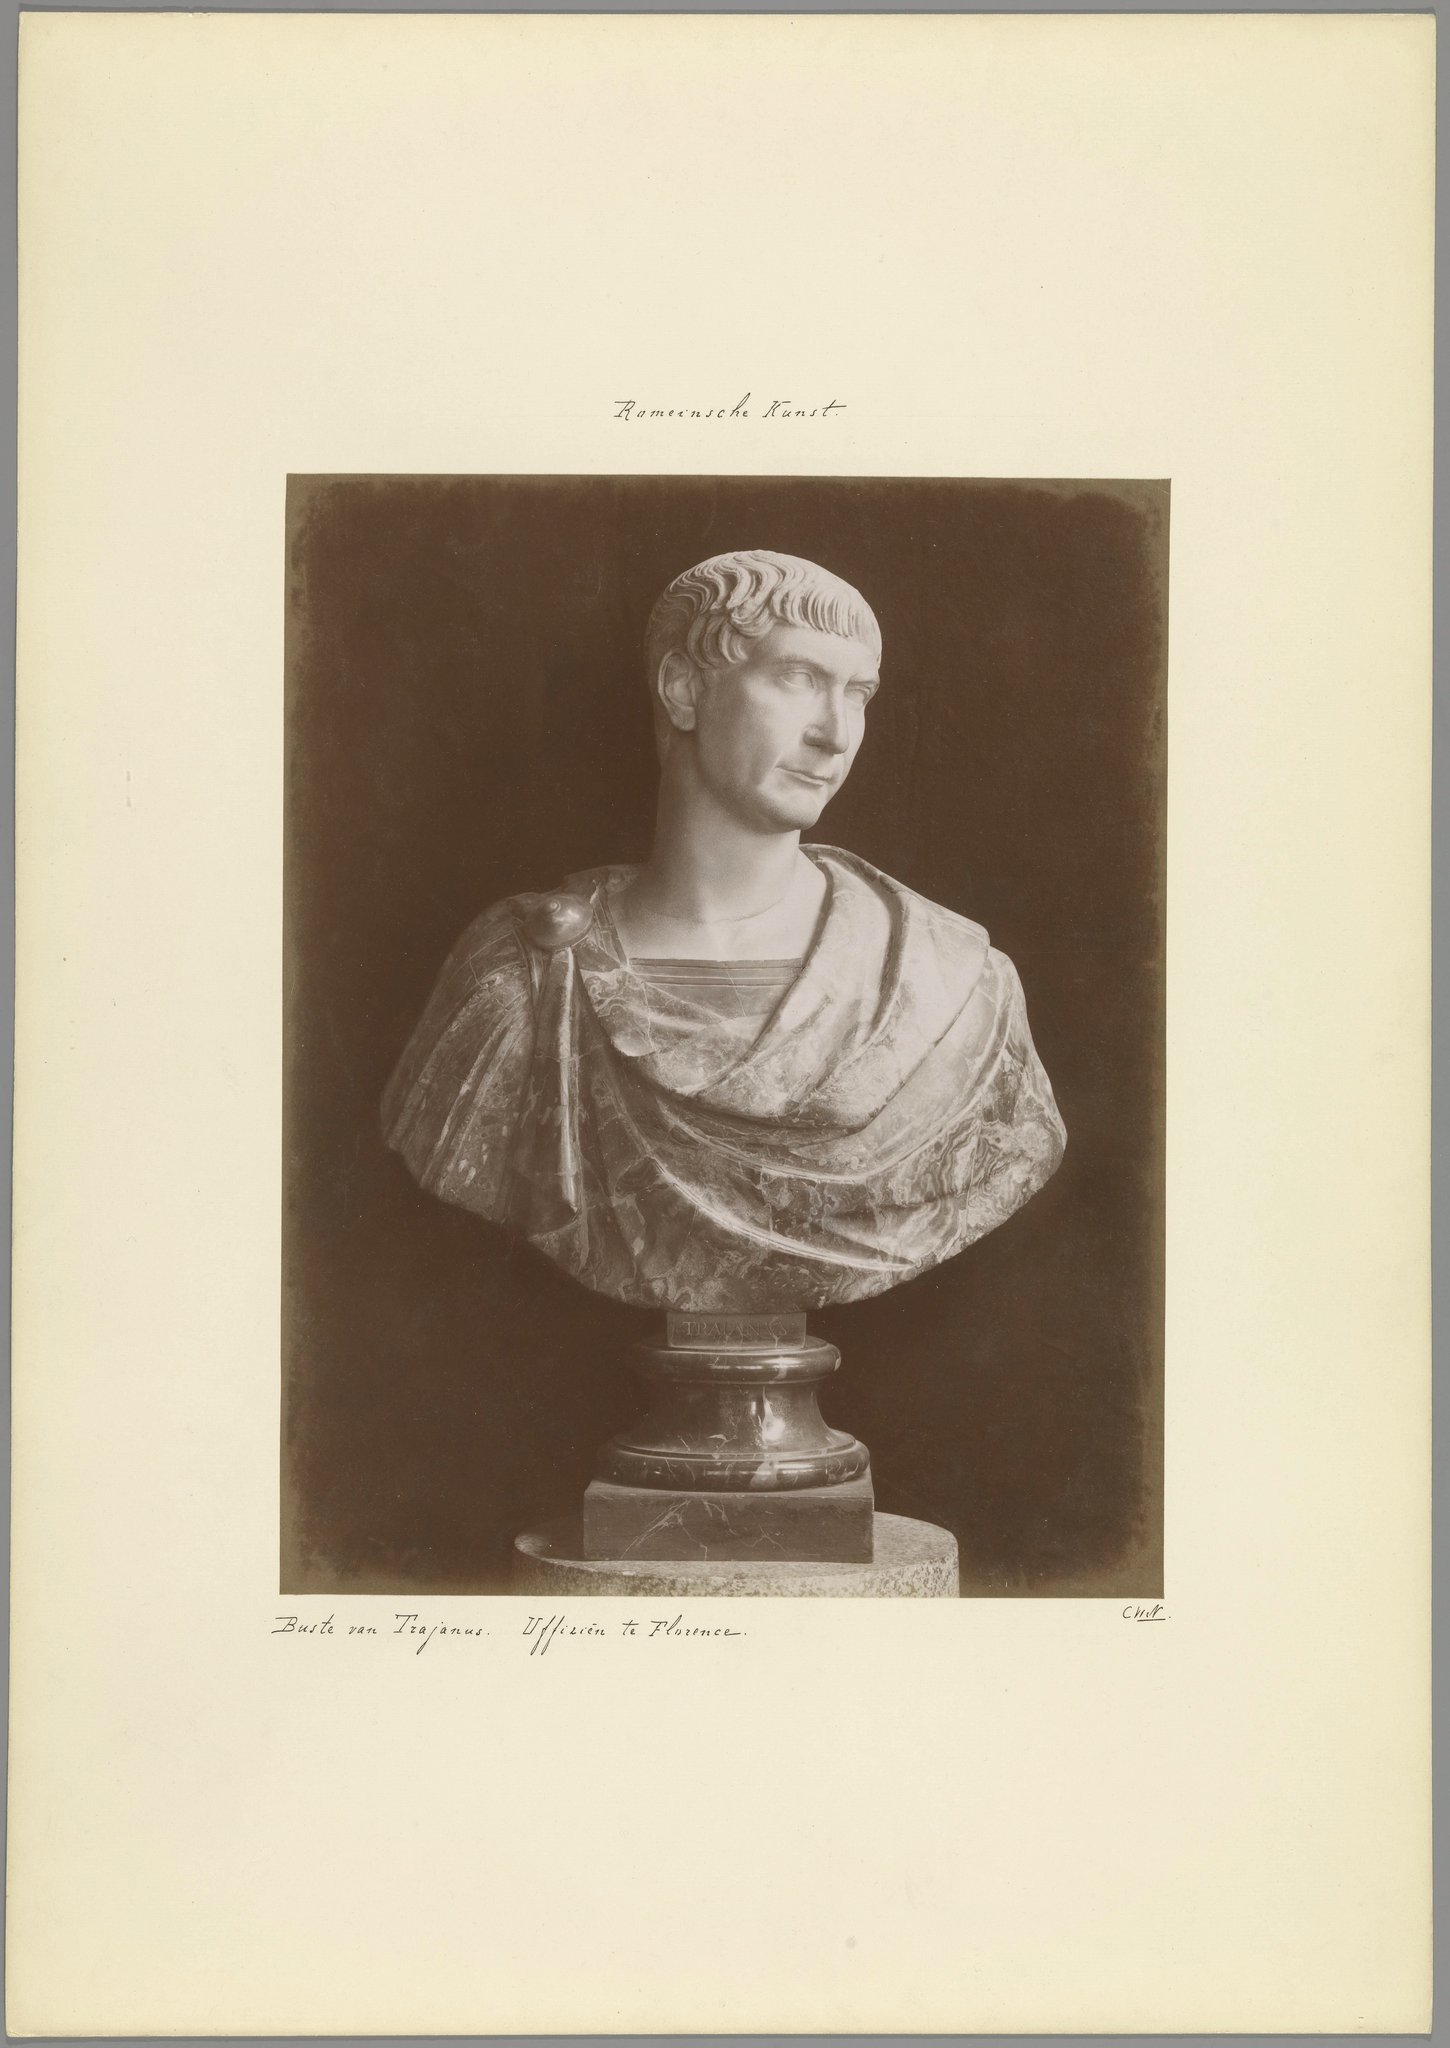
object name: photograph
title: Buste van keizer Trajanus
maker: Anonymous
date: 1875-1900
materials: cardboard, photographic support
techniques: albumen print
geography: galleria degli uffizi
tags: (story of) the emperor trajan, historical persons (+ (full) bust portrait)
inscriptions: inscription: ‘Romeinsche Kunst. Buste van Trajanus. Uffiziën te Florence.’, collector's mark: ‘INSTITUUT VOOR KUNST-NIJVERHEIDSONDERWIJS GABRIËL METSUSTRAAT No. 16. AMSTERDAM’, inscription: ‘CWN.’, collector's mark: ‘KUNSTNIJVERHEIDSCHOOL QUELLINUS AMSTERDAM FRANS HALSSTRAAT 14.’